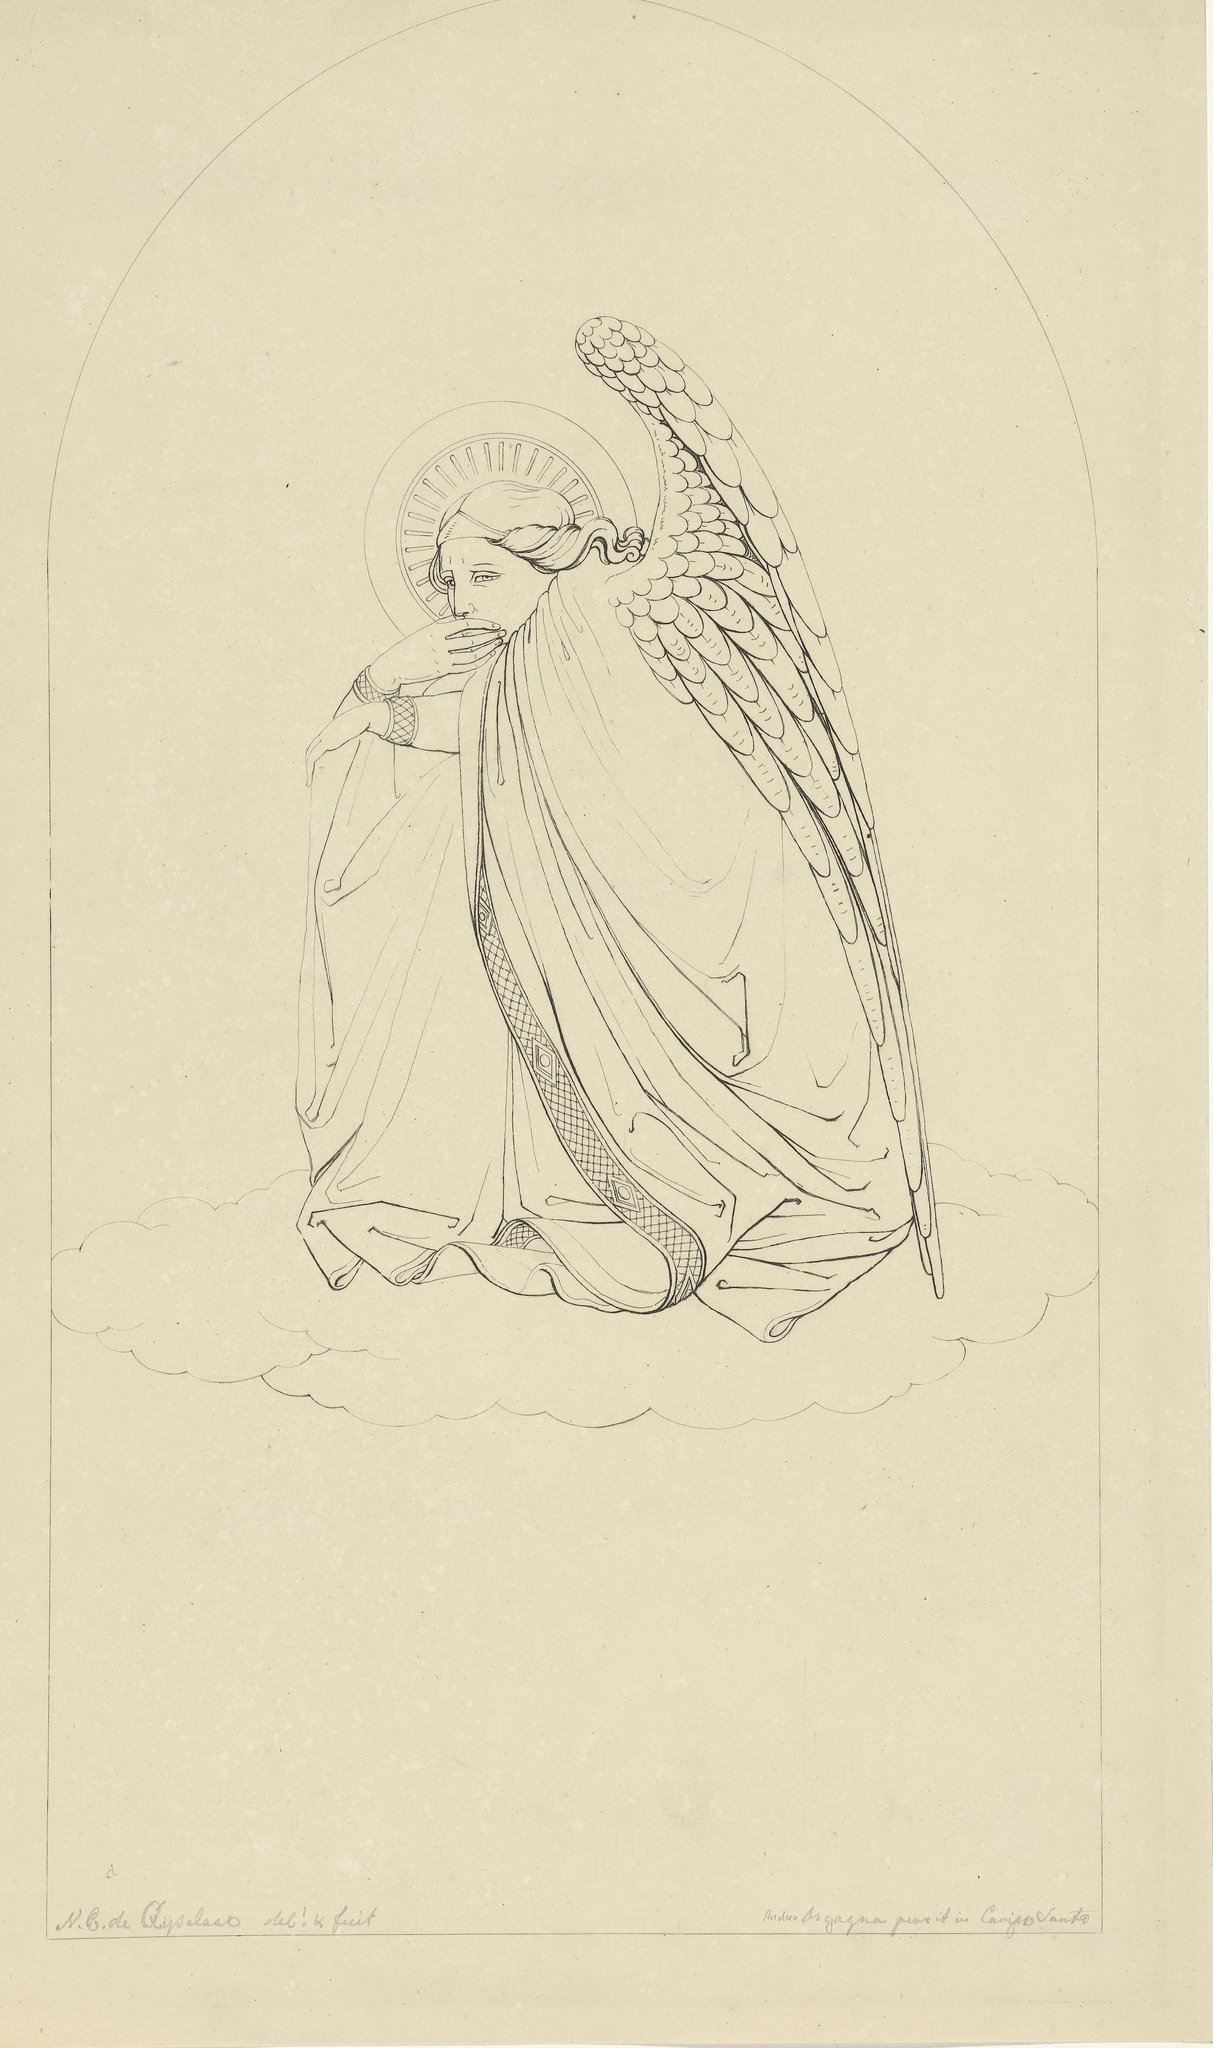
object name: print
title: Gehurkte engel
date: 1802-1873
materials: paper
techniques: etching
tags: angels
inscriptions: collector's mark: Lugt 2228, inscription: ‘Pl. X’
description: Een gehurkte engel met de hand voor de mond.